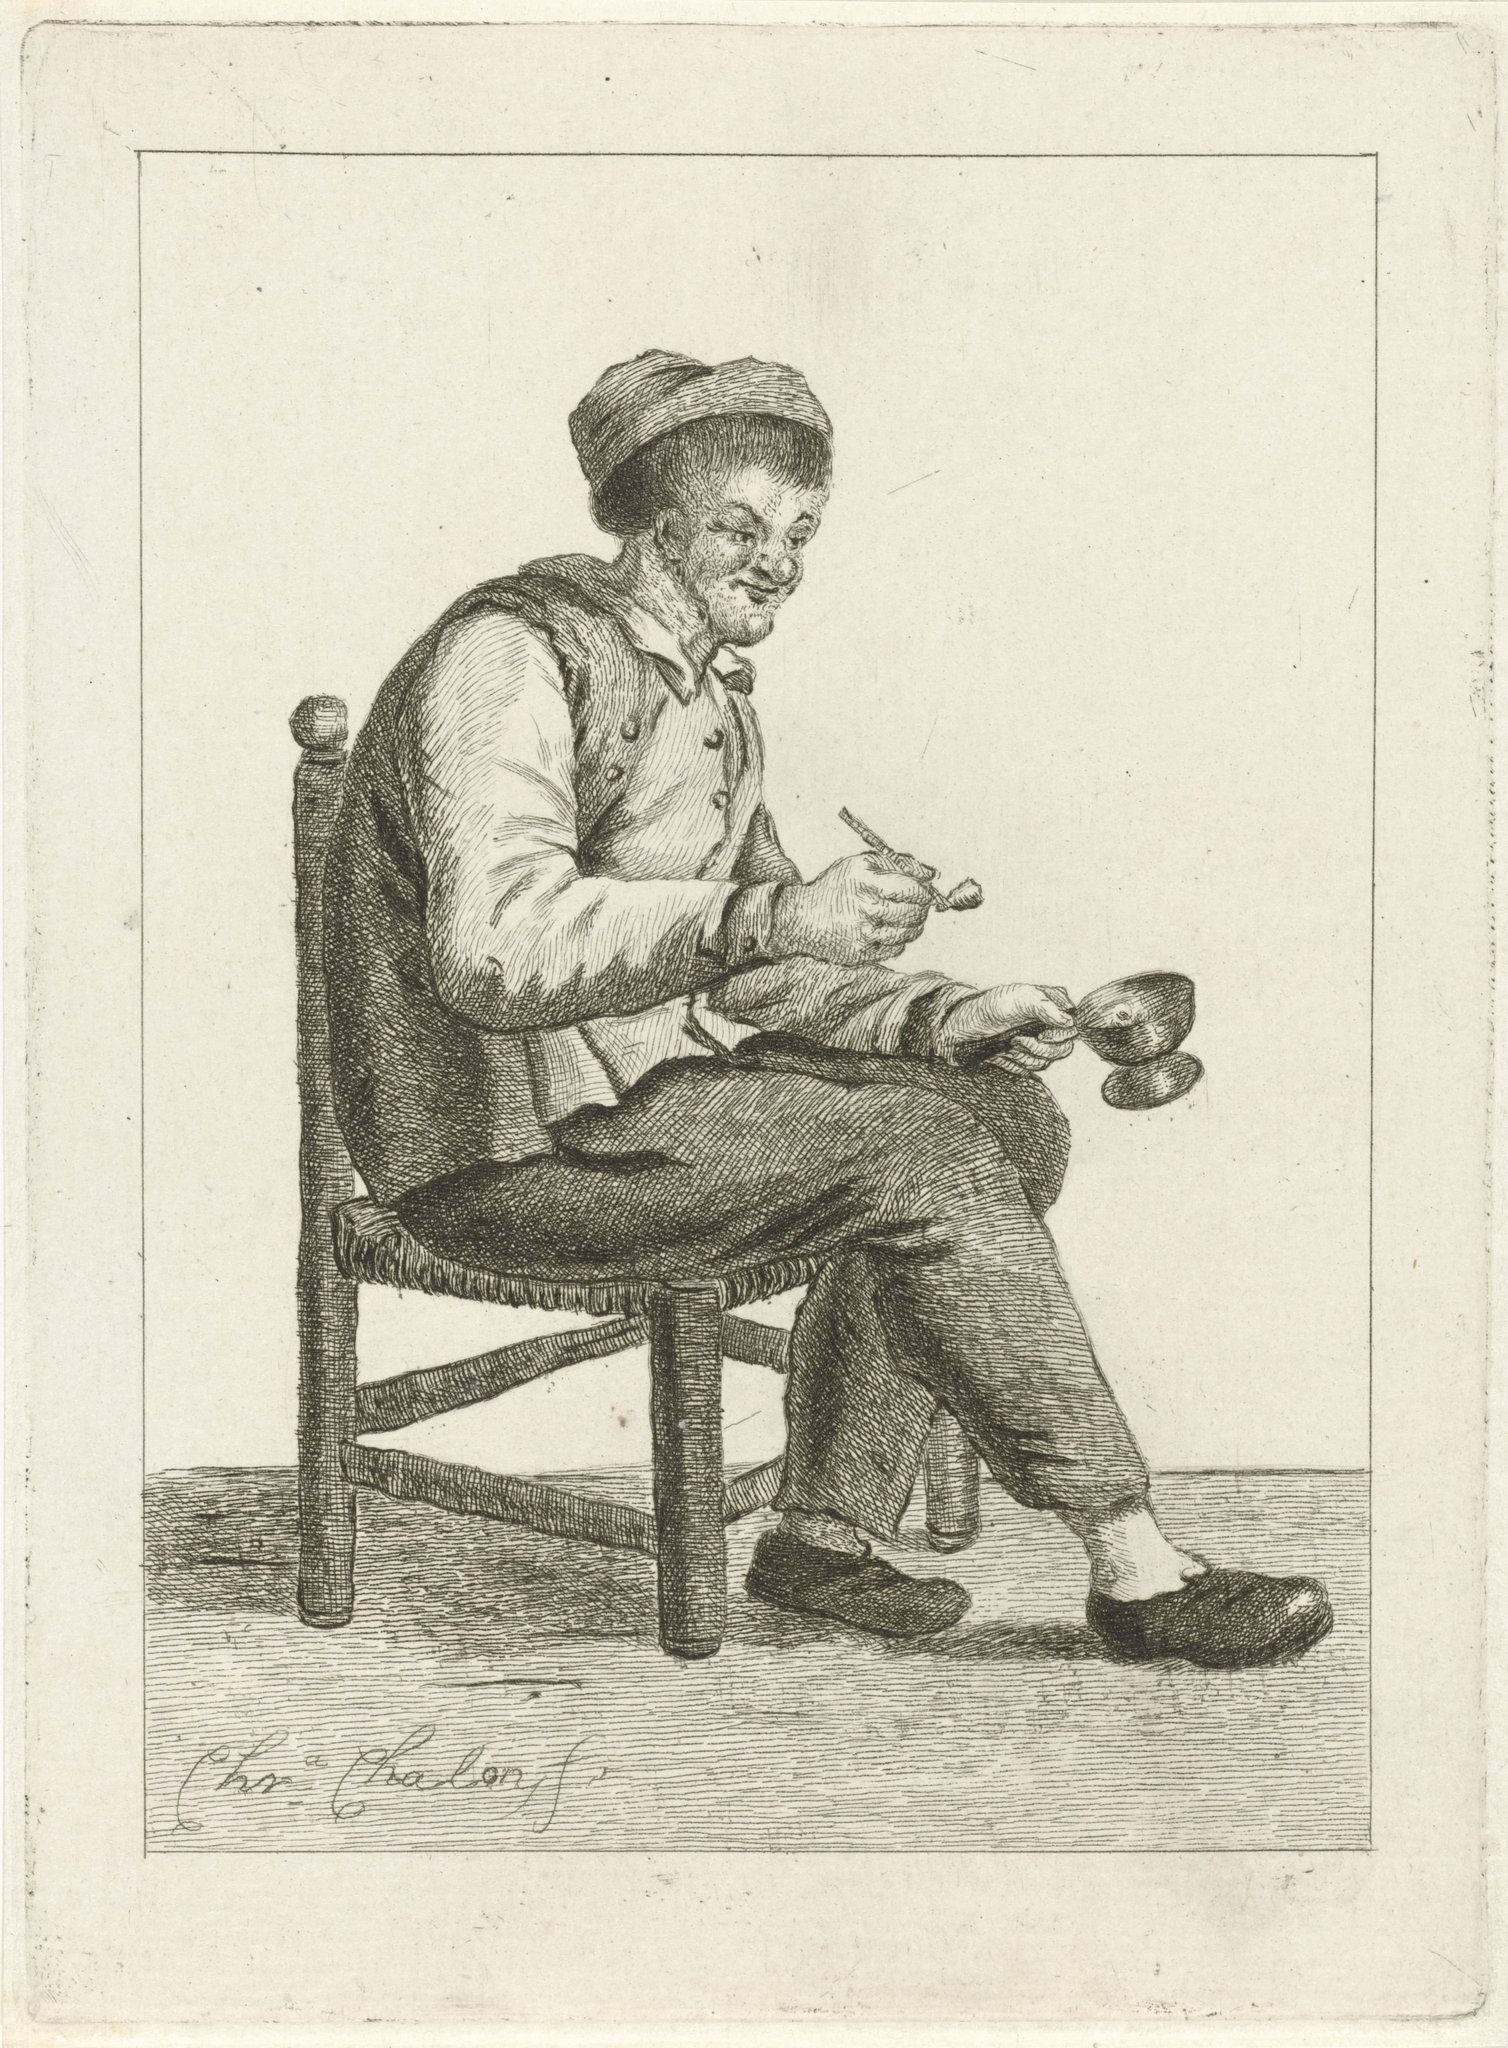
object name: print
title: Zittende pijproker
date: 1779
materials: paper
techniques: etching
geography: leiden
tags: sitting figure, pipe ~ tobacco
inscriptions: collector's mark: Lugt 240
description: Een man met een pijp zittend op een stoel. In zijn hand heeft hij een test met een kooltje vuur.